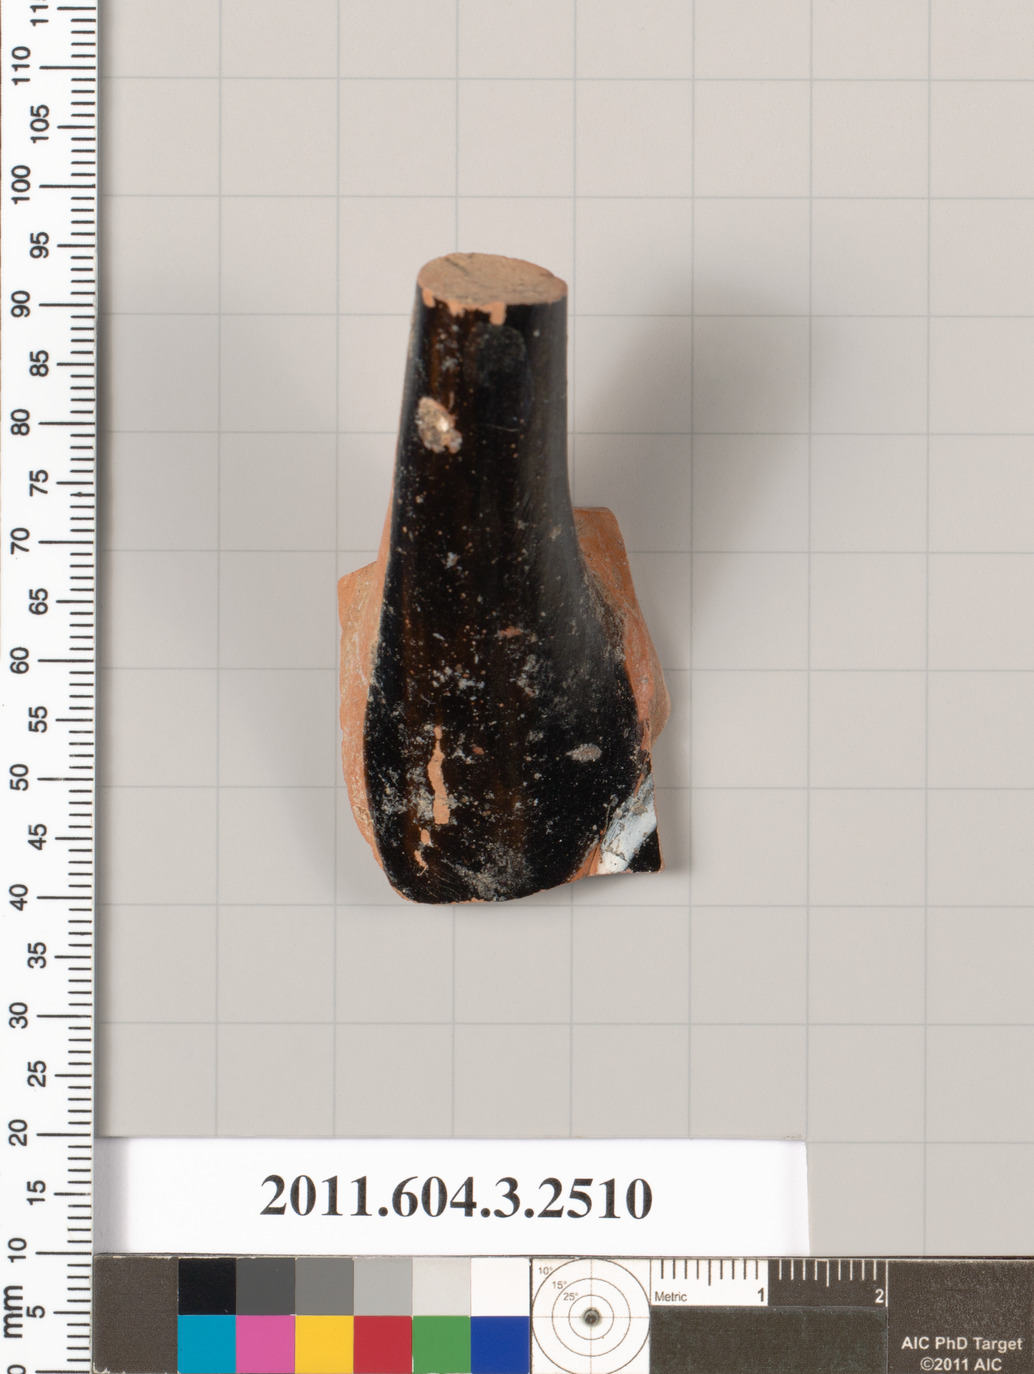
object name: kylix fragment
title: Terracotta fragment of a kylix: eye-cup (drinking cup)?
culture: greek, attic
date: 600-401 BCE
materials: terracotta